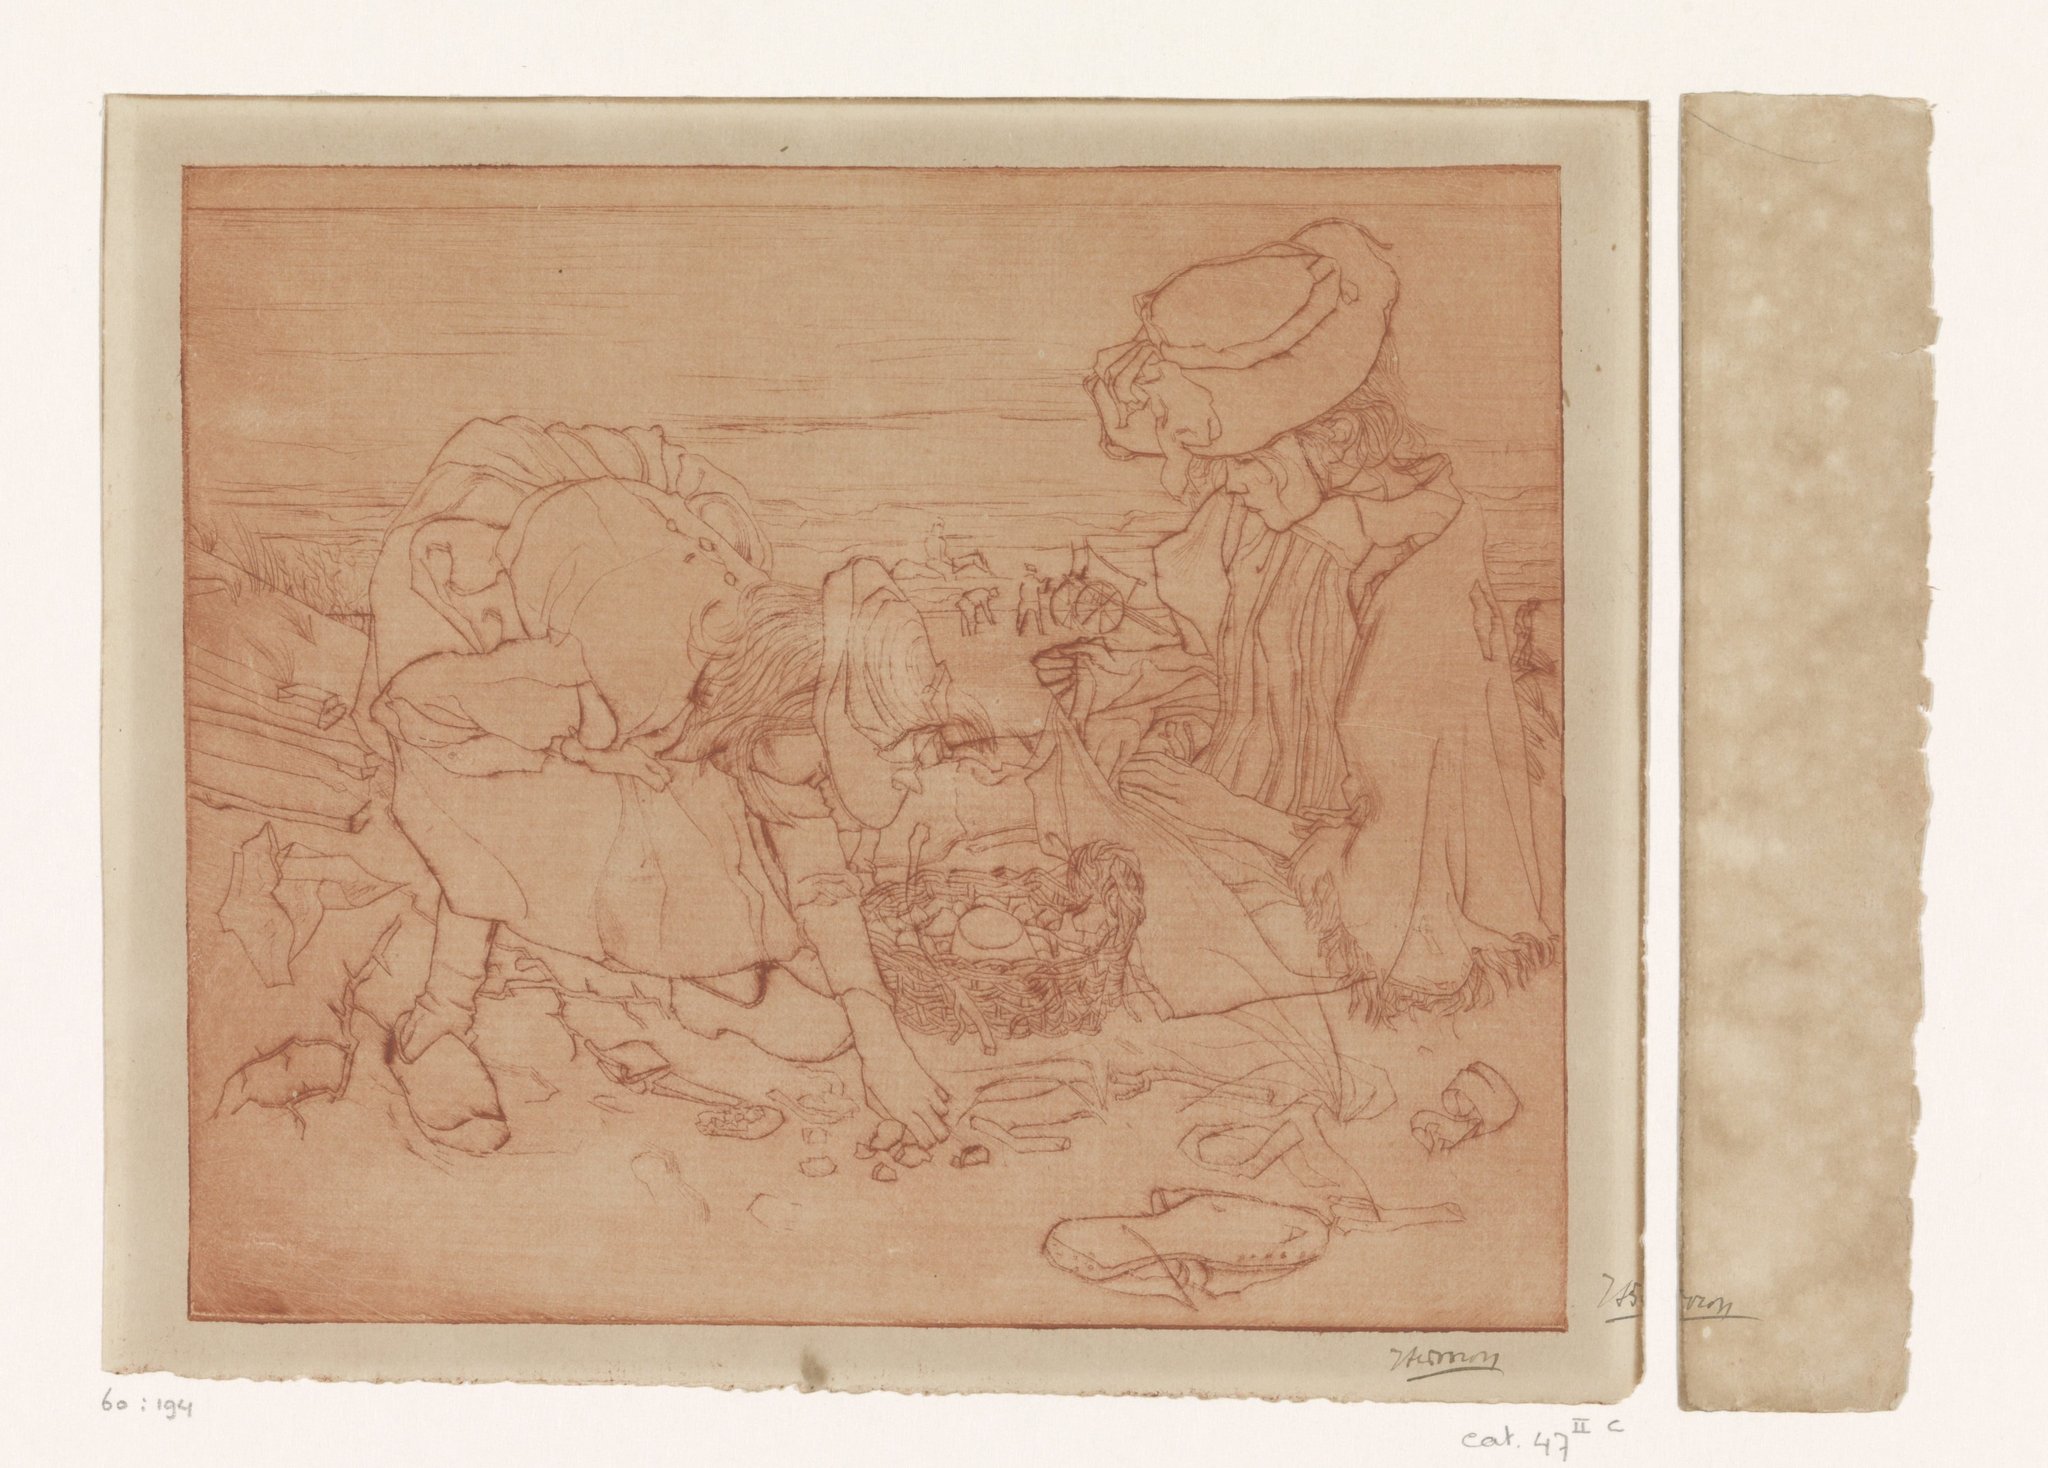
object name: print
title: Twee schelpen verzamelende meisjes op het strand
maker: jan toorop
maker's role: draughtsman, painter, print maker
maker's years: 1858-1928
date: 1873-1928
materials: paper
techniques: drypoint, intaglio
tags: beach (as place of recreation), girl (child between toddler and youth)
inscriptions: collector's mark: Lugt 2228